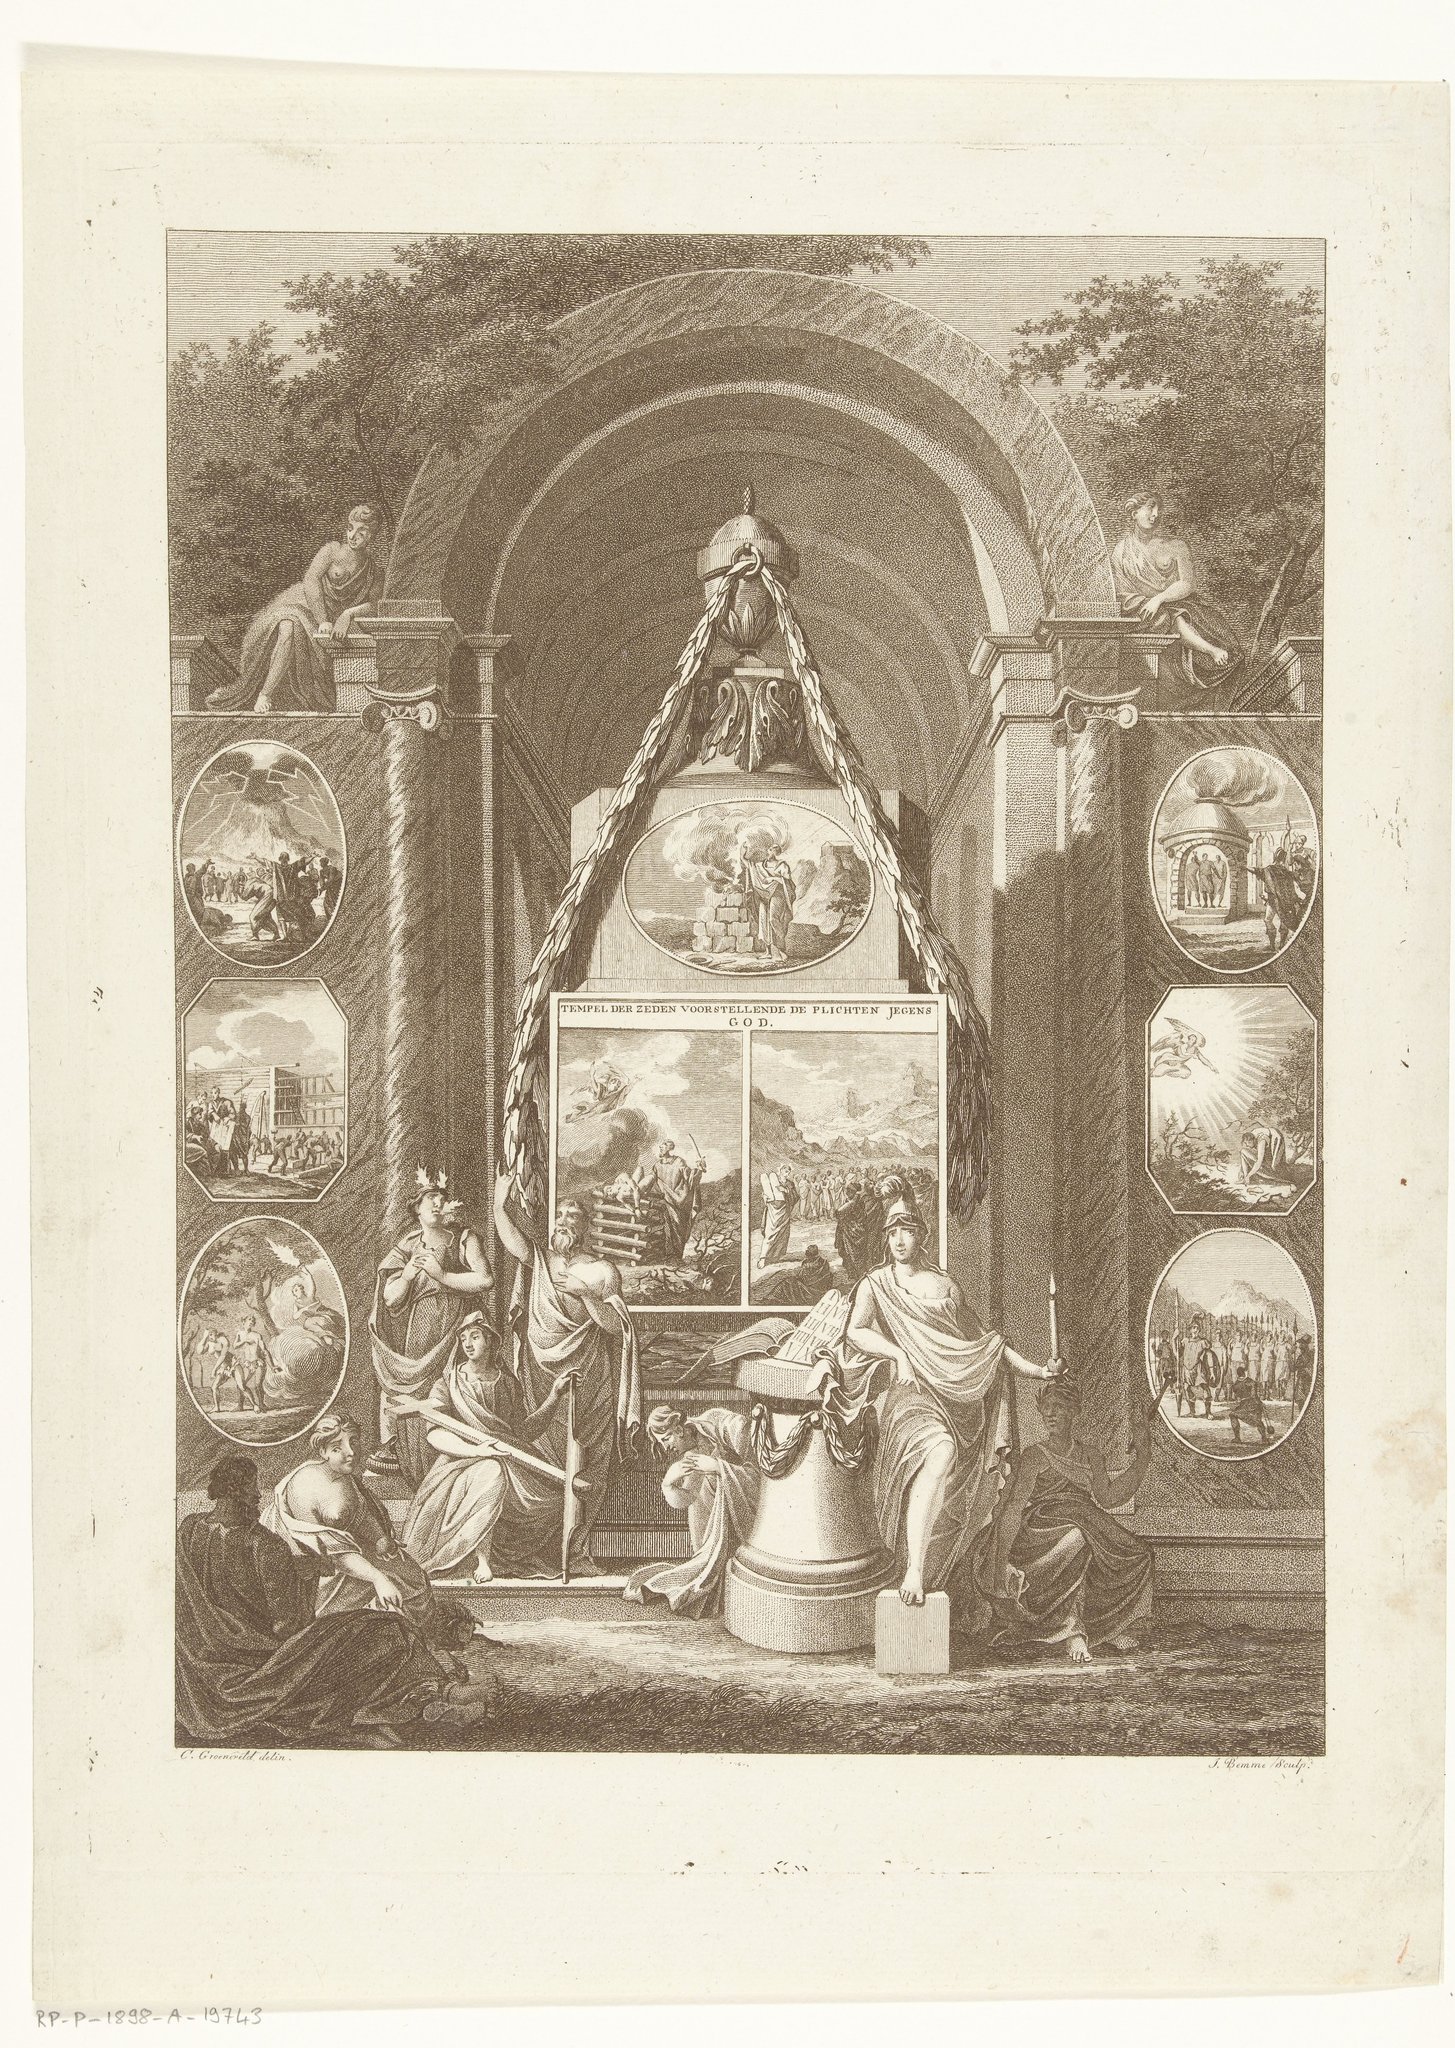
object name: print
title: Tempel der zeden voorstellende de plichten jegens God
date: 1800-1841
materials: paper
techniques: etching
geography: rotterdam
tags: the sacrifice of isaac (genesis 22), expulsion of adam and eve from paradise (genesis 3:22-24), the new tables of the law (exodus 34)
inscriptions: collector's mark: Lugt 2228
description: Een monument met plaquettes, waarop scènes uit het Oude Testament, onder een boog. Op de boog eveneens bijbelsescènes. Vóór het monument een verzameling van allegorische figuren.